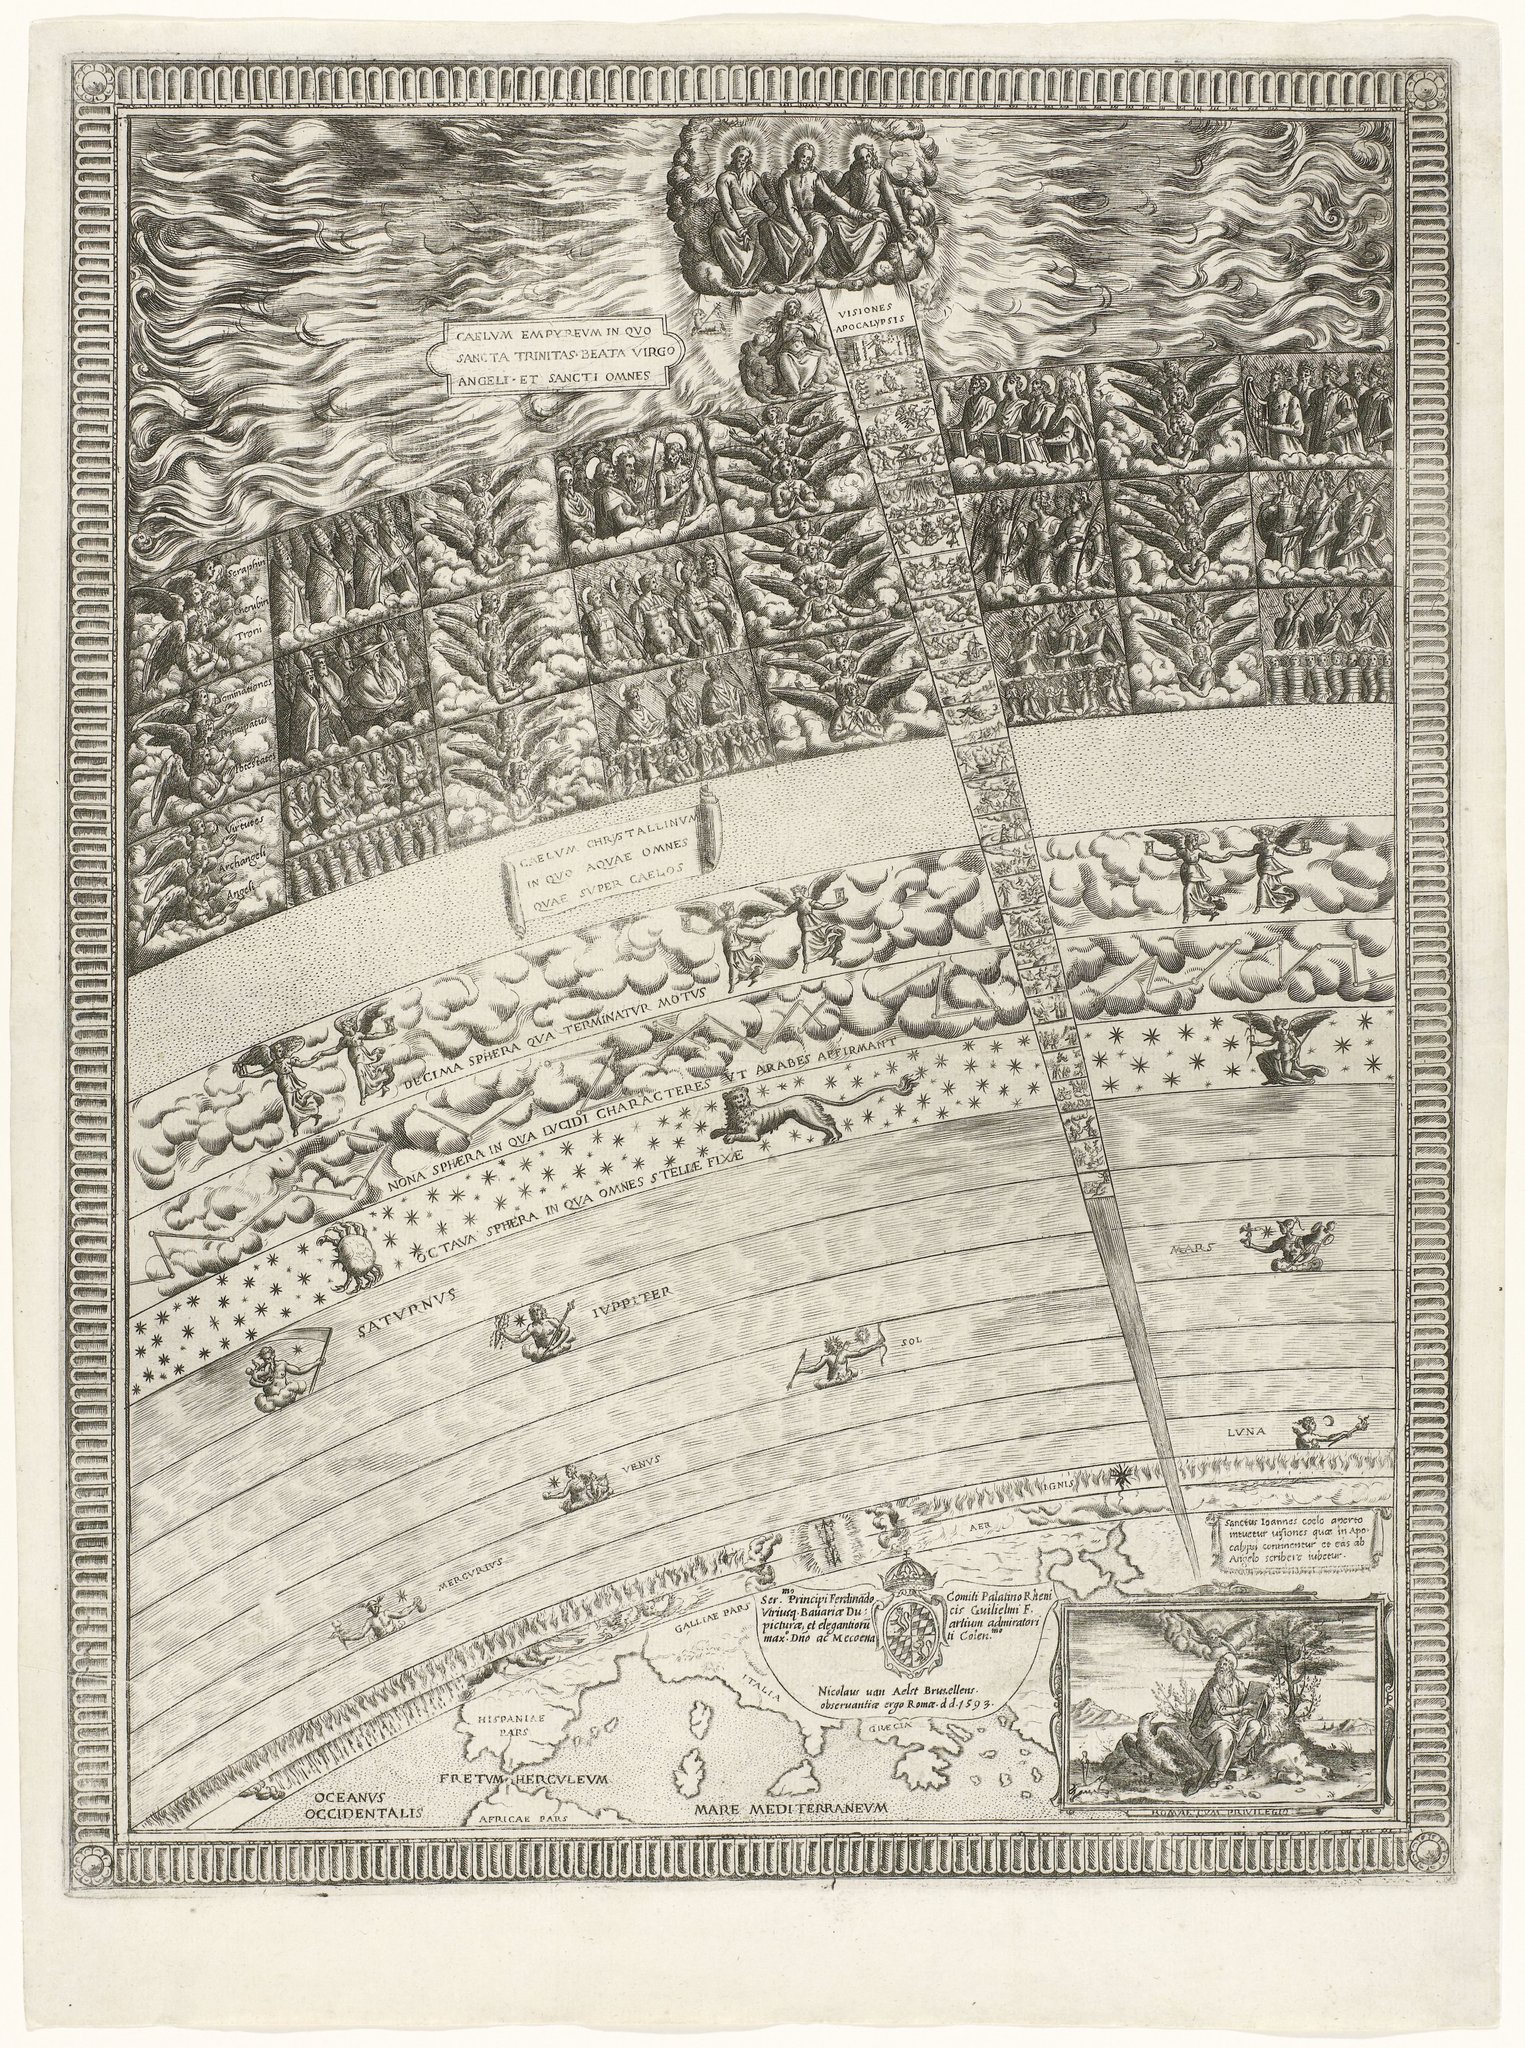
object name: print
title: Hemelkaart met dwarsdoorsnede van de hemelsferen en Openbaringen van Johannes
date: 1593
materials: paper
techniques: engraving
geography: rome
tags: heaven, celestial paradise, new earth, john (writing) on the island of patmos, possibly the eagle beside him, representations of the trinity, the revelation of john, the apocalypse, spheres ~ heavens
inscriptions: collector's mark: Lugt 2228, collector's mark: Lugt 2760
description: Kaart met een dwarsdoorsnede van de hemelsferen volgens het pre-Copernicaanse wereldbeeld. Linksonder een cartografische weergave van het noordelijke Middellandse Zeegebied met in een cartouche een voorstelling van Johannes op Patmos. Hierboven zijn de verschillende hemelsferen voorgesteld in boven elkaar geplaatste banen: de vijf elementen, de planeten, de sterrenbeelden, de kristallijne hemel, de verschillende engelenscharen en heiligen, en ten slotte de Heilige Maagd en de Drie-eenheid. In een baan, lopend vanaf rechtsonder naar de Drie-eenheid midden boven, zijn verschillende scènes weergegeven uit de Apocalyps. Het geheel is omgeven door een ornamentlijst.